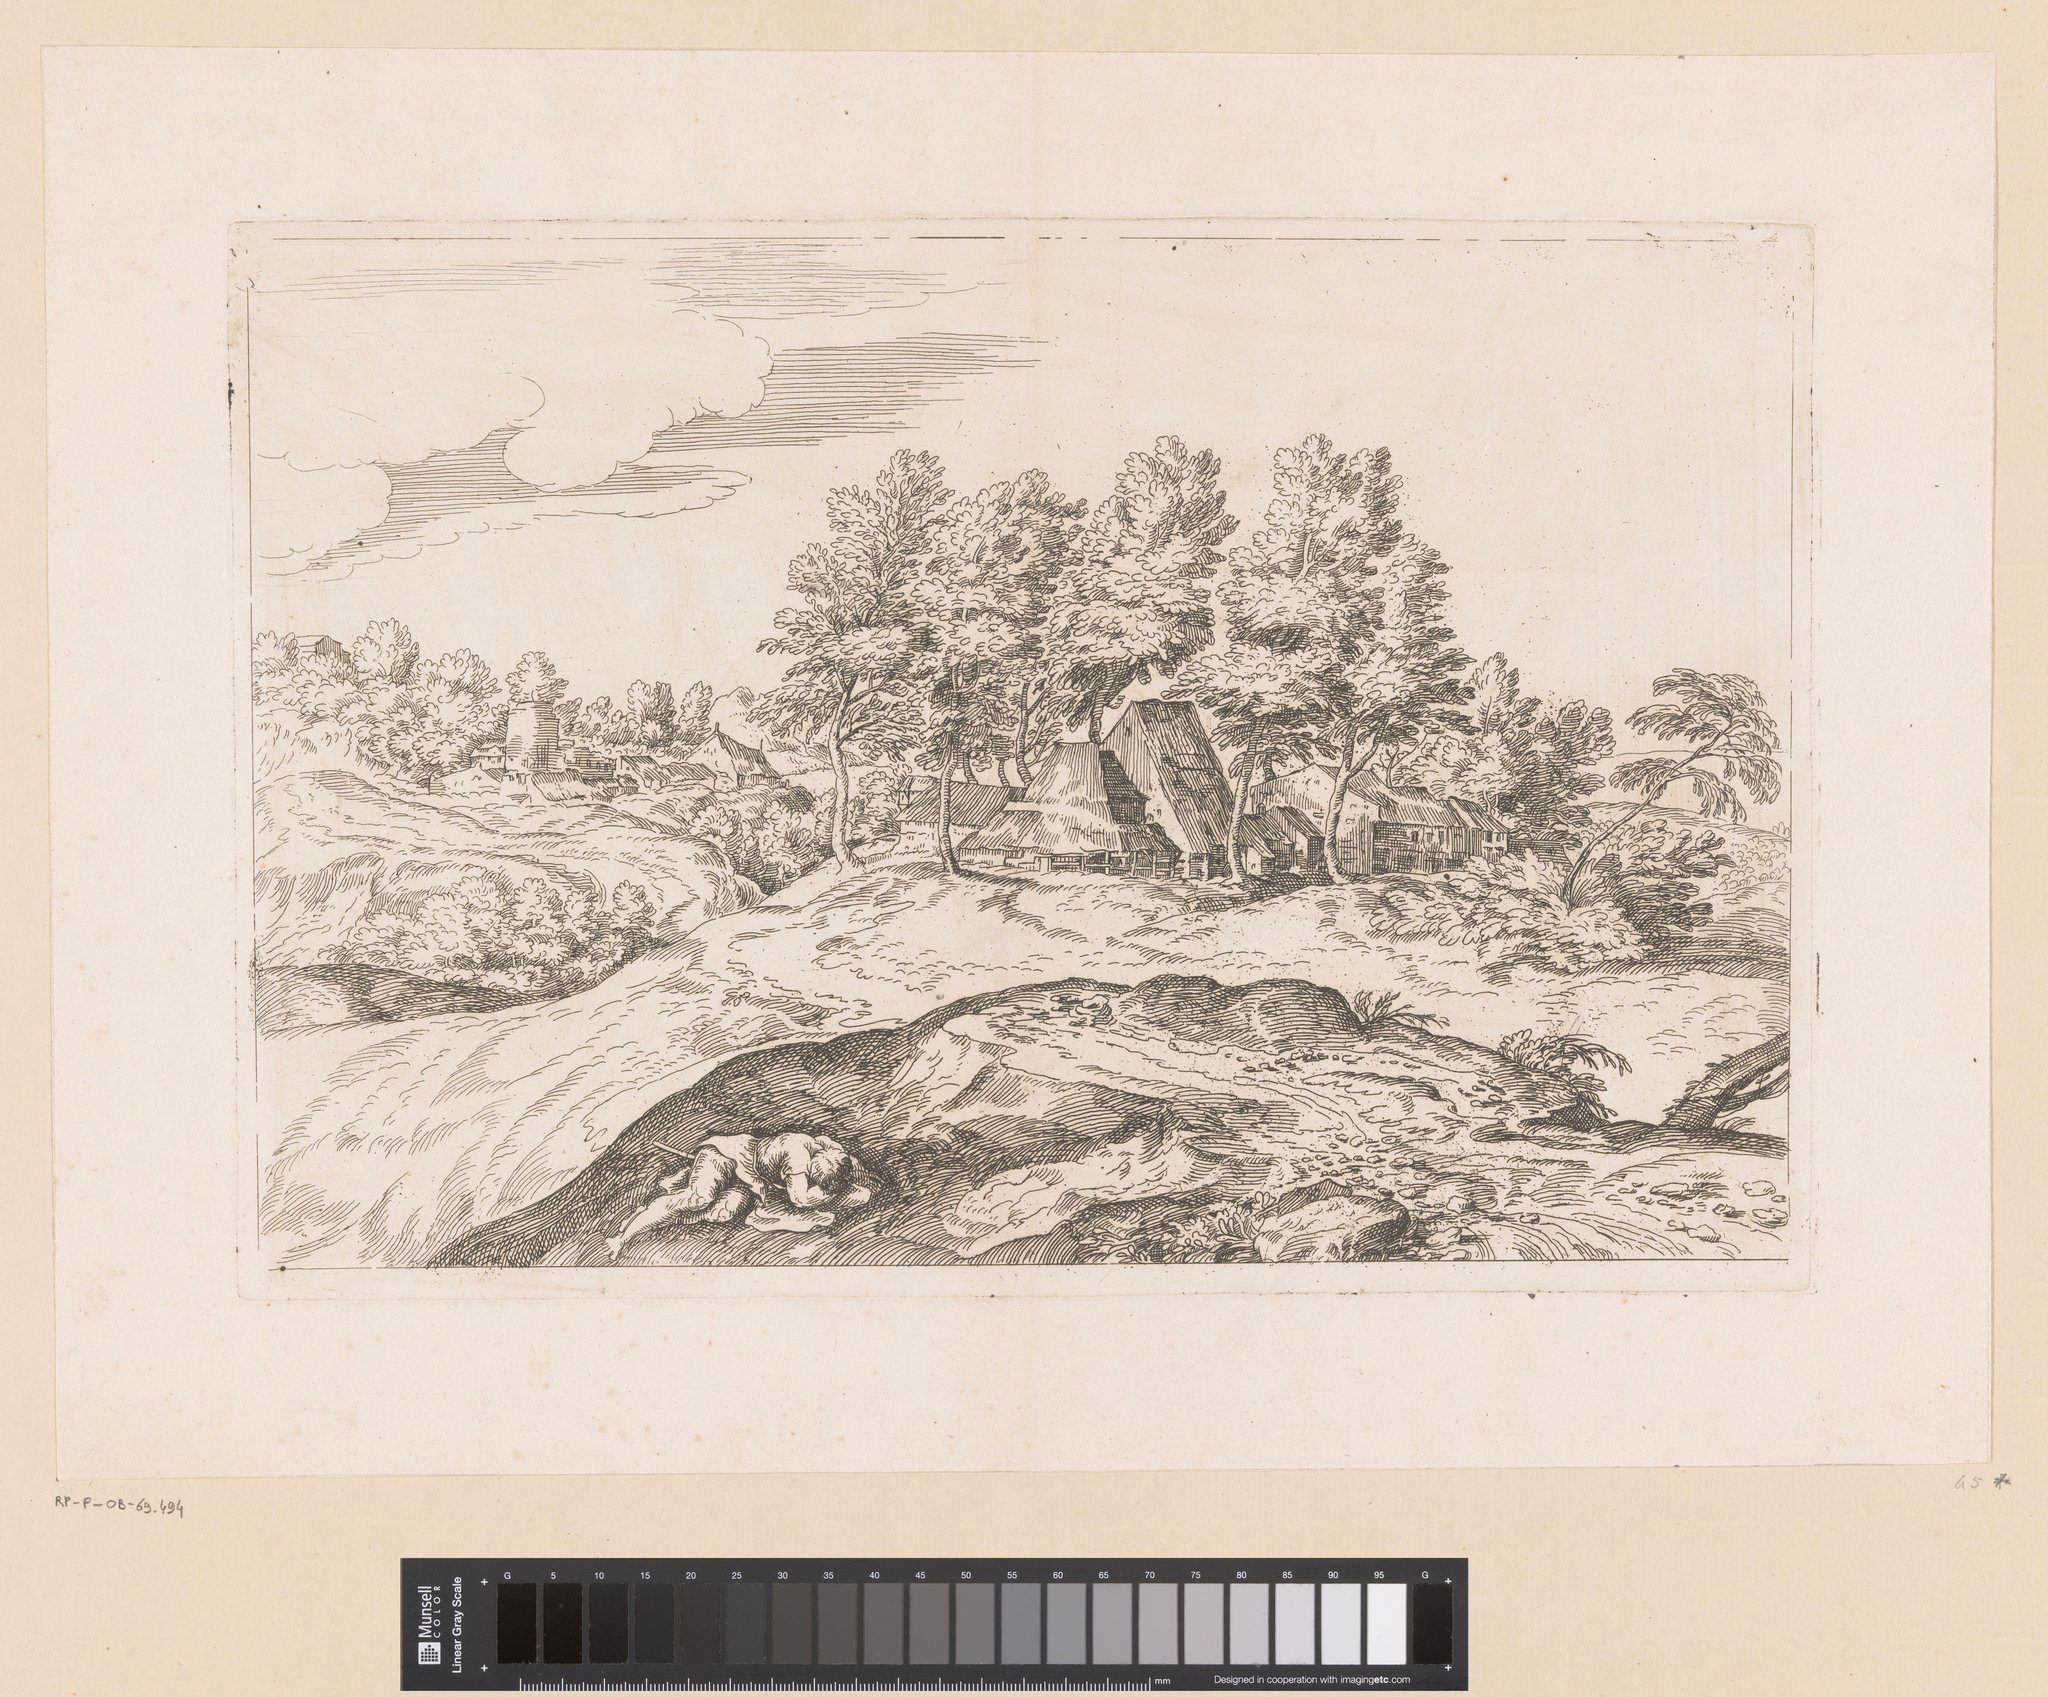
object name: print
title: Landschappen naar Campagnola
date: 1634-1679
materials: paper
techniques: etching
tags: landscapes in the temperate zone, sleeping; unconsciousness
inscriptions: collector's mark: Lugt 240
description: Naar een prent uit een 24-delige serie naar tekeningen van landschappen toegeschreven aan Campagnola, of de school van Campagnola (zie British Museum, inv.nr. S.6782). Plaat twee uit de serie betreft waarschijnlijk echter een ontwerp van Titaan (zie British Museum, inv.nr. S.6783).